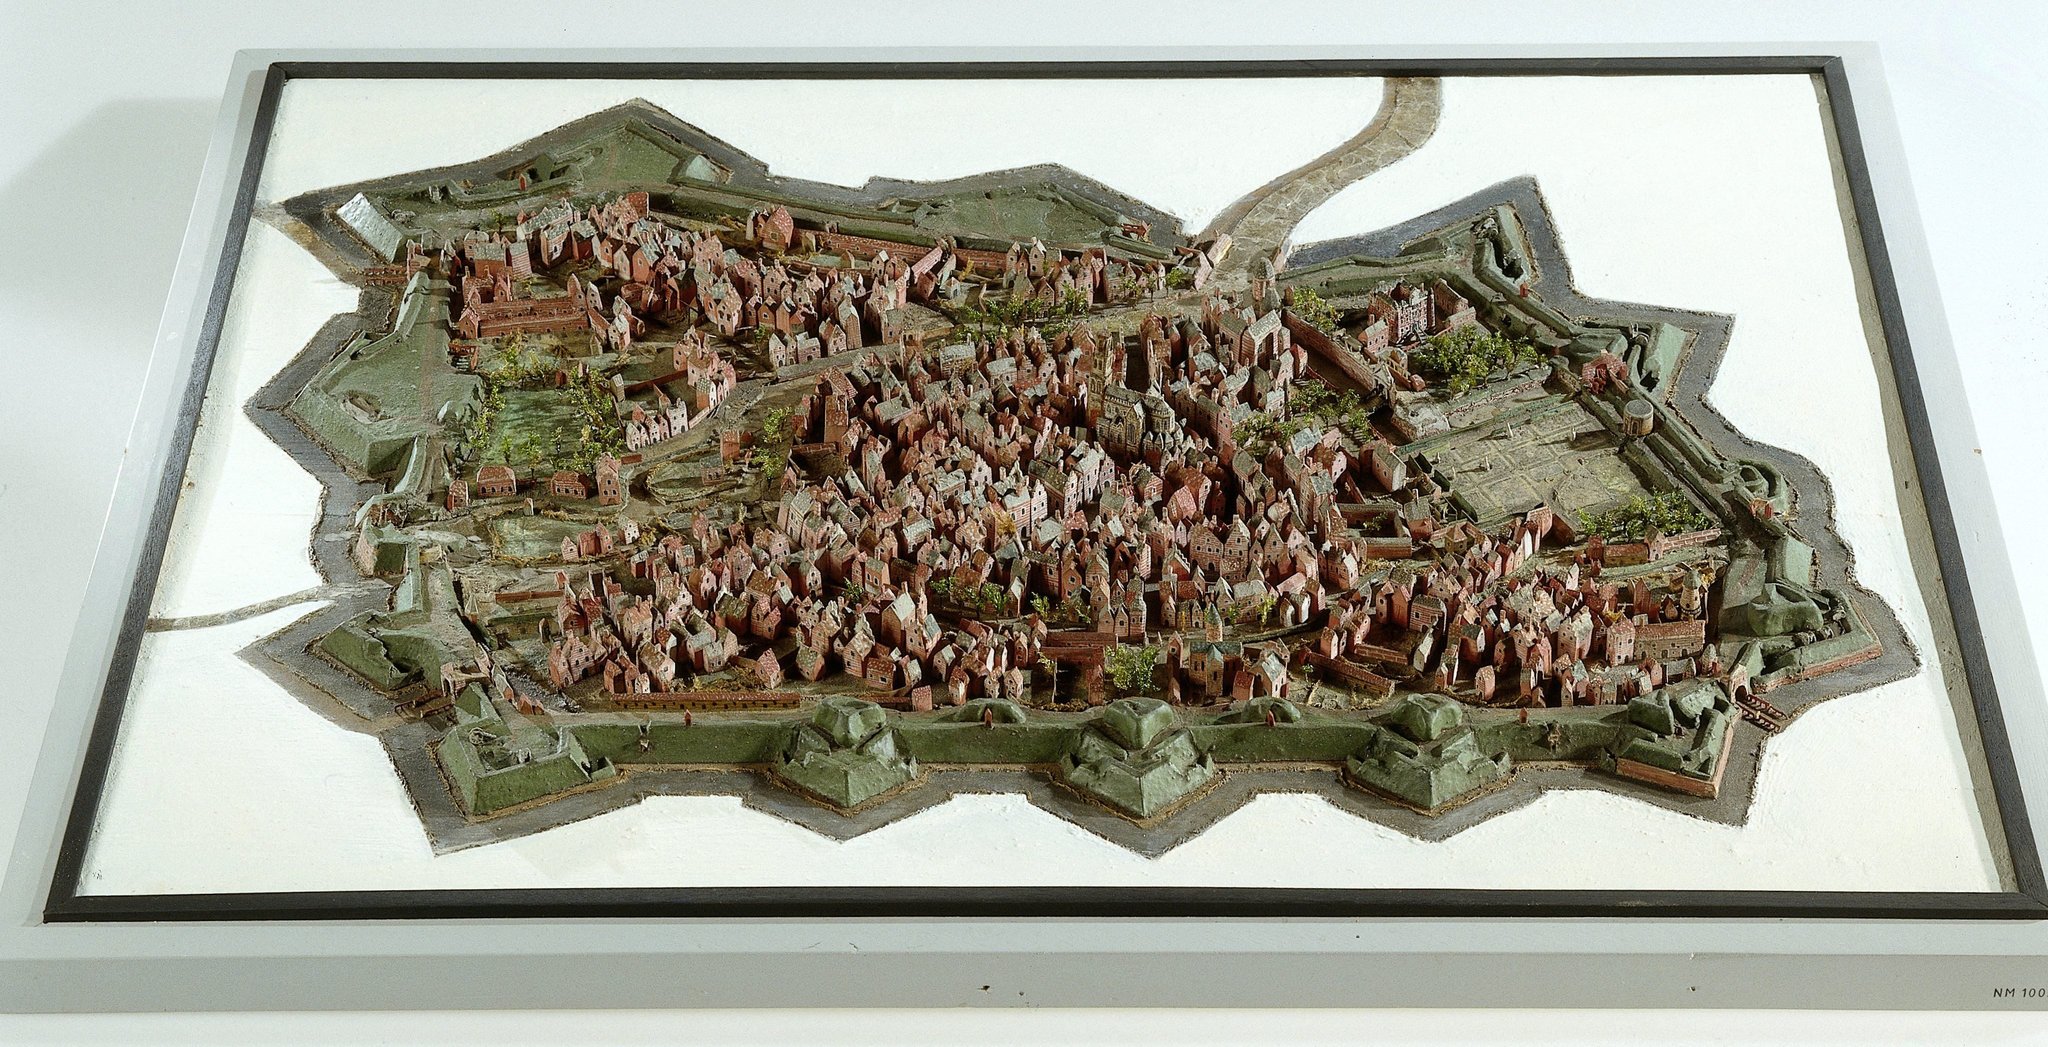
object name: maquette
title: Stadsplan in reliëf van de stad Breda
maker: cornelis van bergen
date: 1750-1800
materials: gypsum, iron, oil, paper, plastic, fiber, varnish, wood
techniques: modeling, sawing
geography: breda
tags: the hague, william iii (prince of orange and king of england, scotland, and ireland)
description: Model of the fortress at Breda, late 17th century. The war that engulfed the Republic in 1672 forced its leaders to focus on the country's defences. Stadholder William III ordered the modernisation of the dilapidated fortifications around the Dutch cities. The model shows the city of Breda with the defences built in 1682. The houses in the model are carved in wood. The town walls are made of clay.